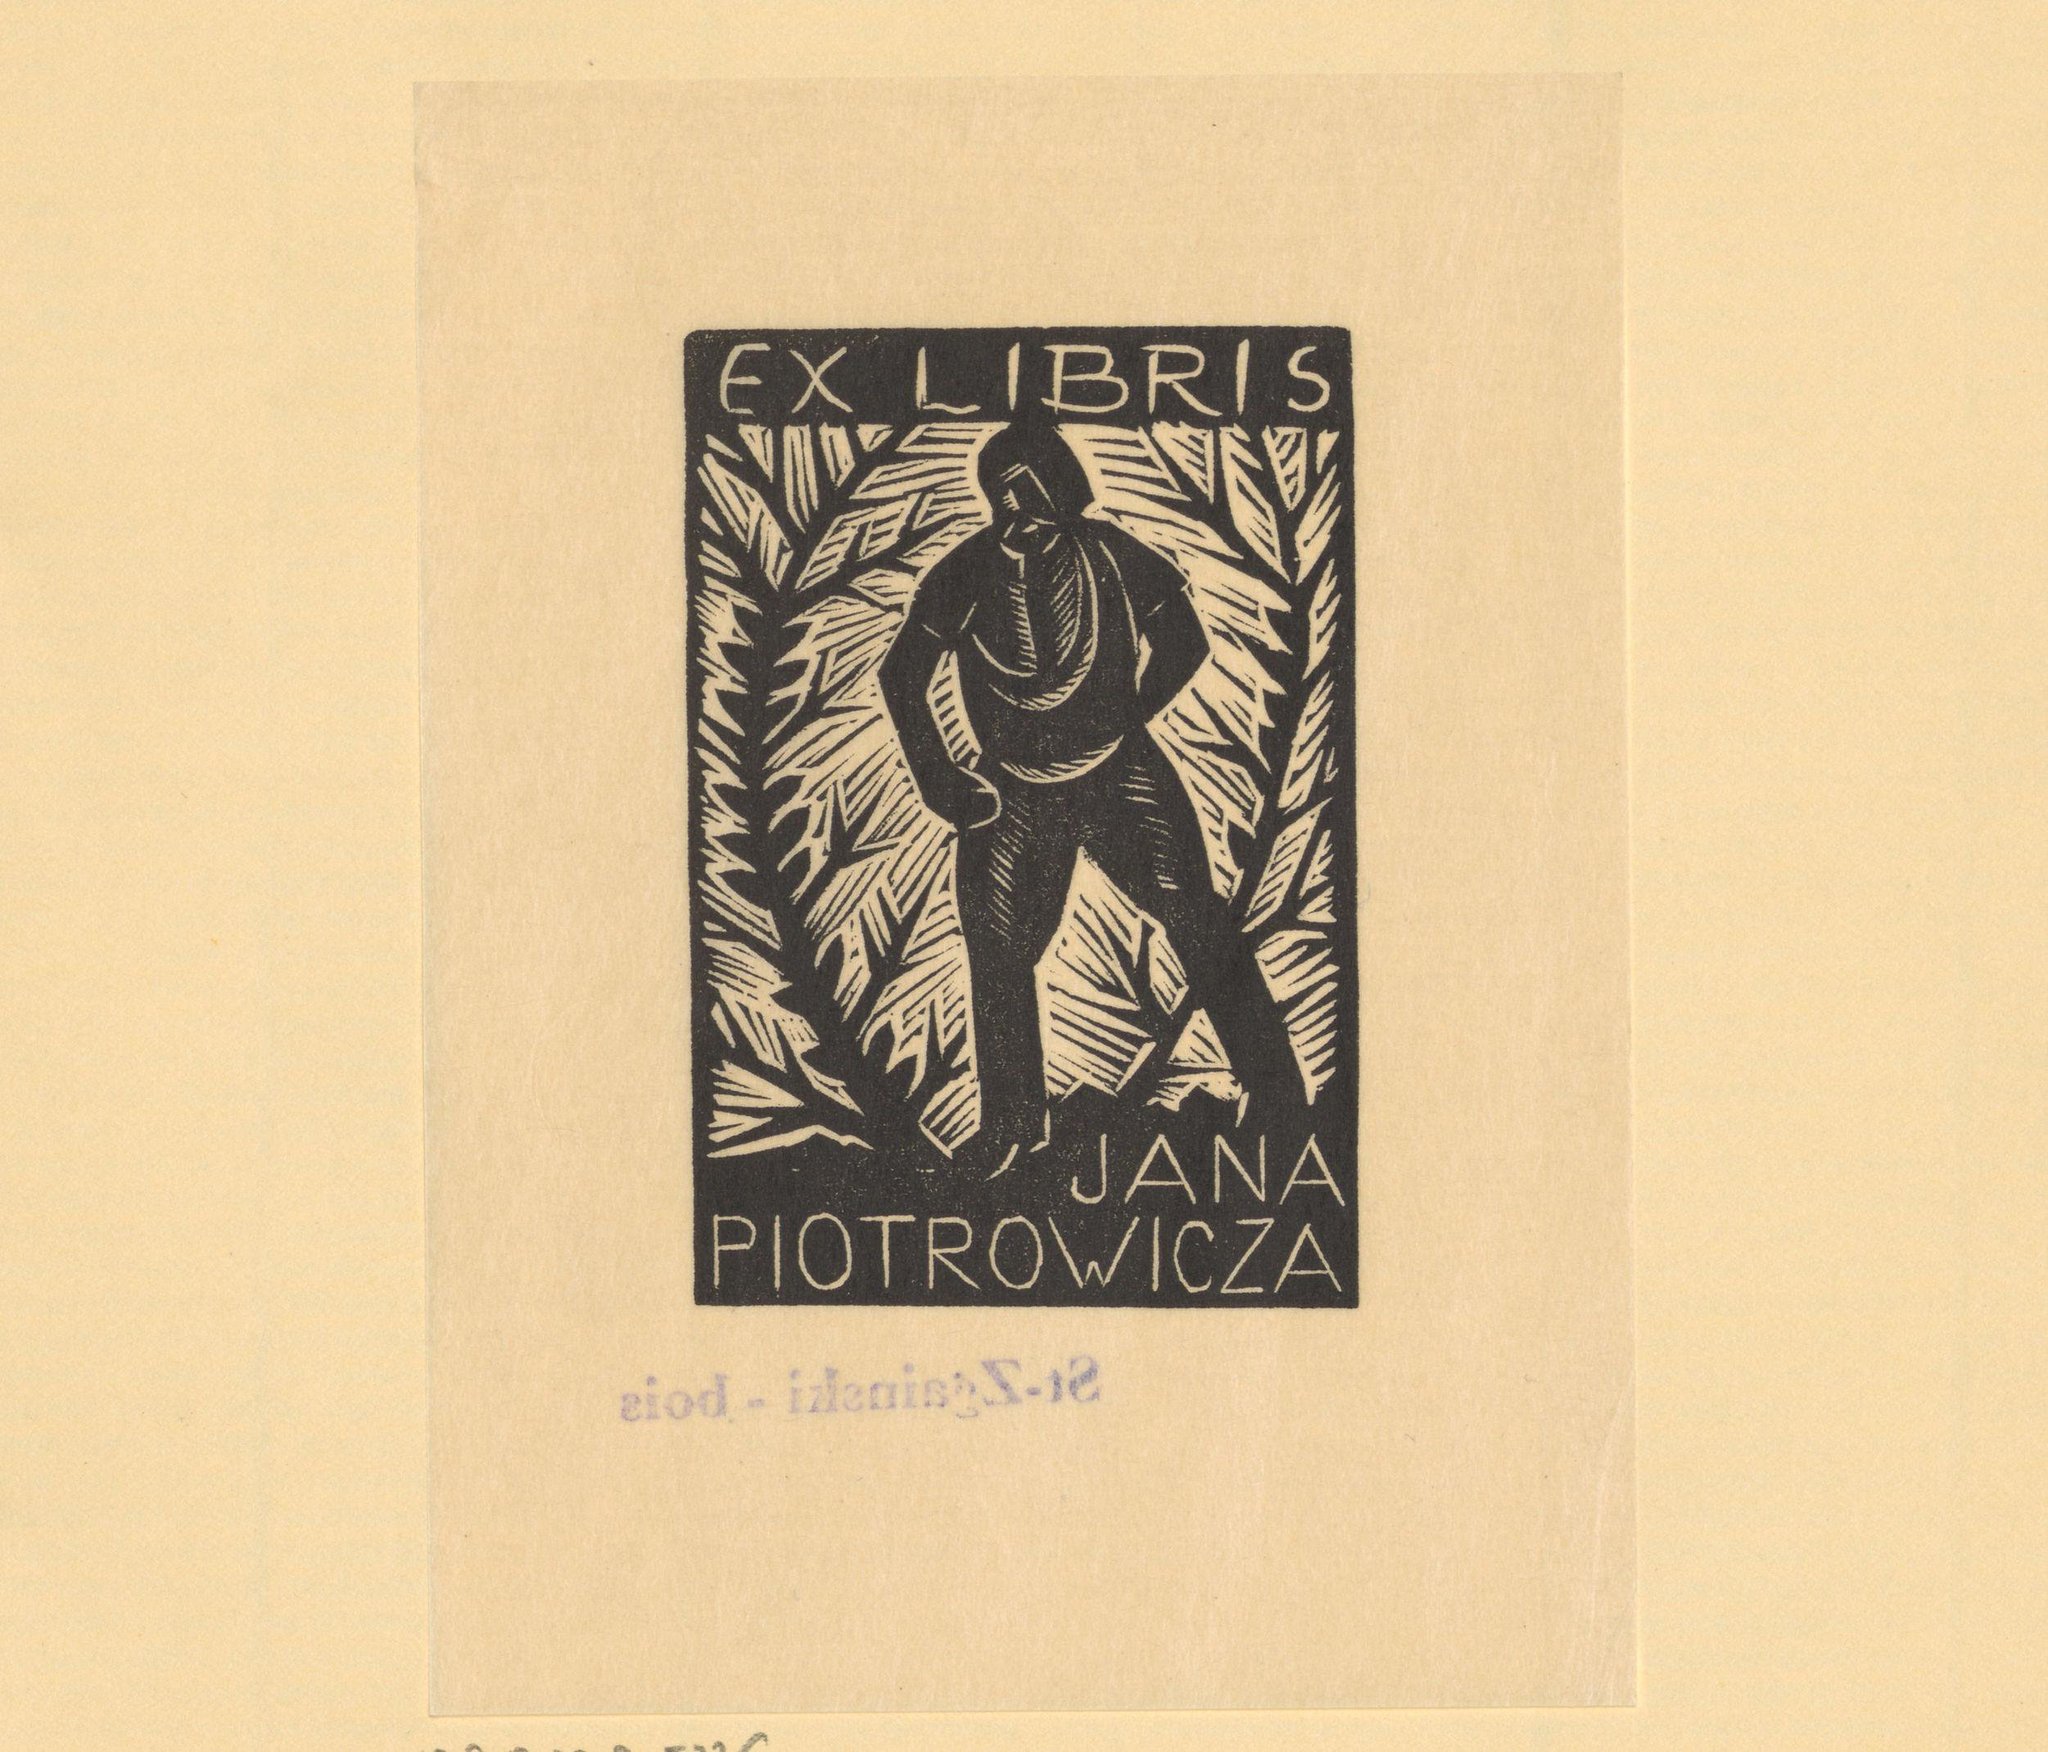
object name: bookplate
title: Ex libris Jana Piotrowicza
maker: stanislaw zalinski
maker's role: print maker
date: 1900-1949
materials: paper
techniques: woodcut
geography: poland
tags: standing figure, trees, sowing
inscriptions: workshop stamp: ‘St. Zgalinski - bois’